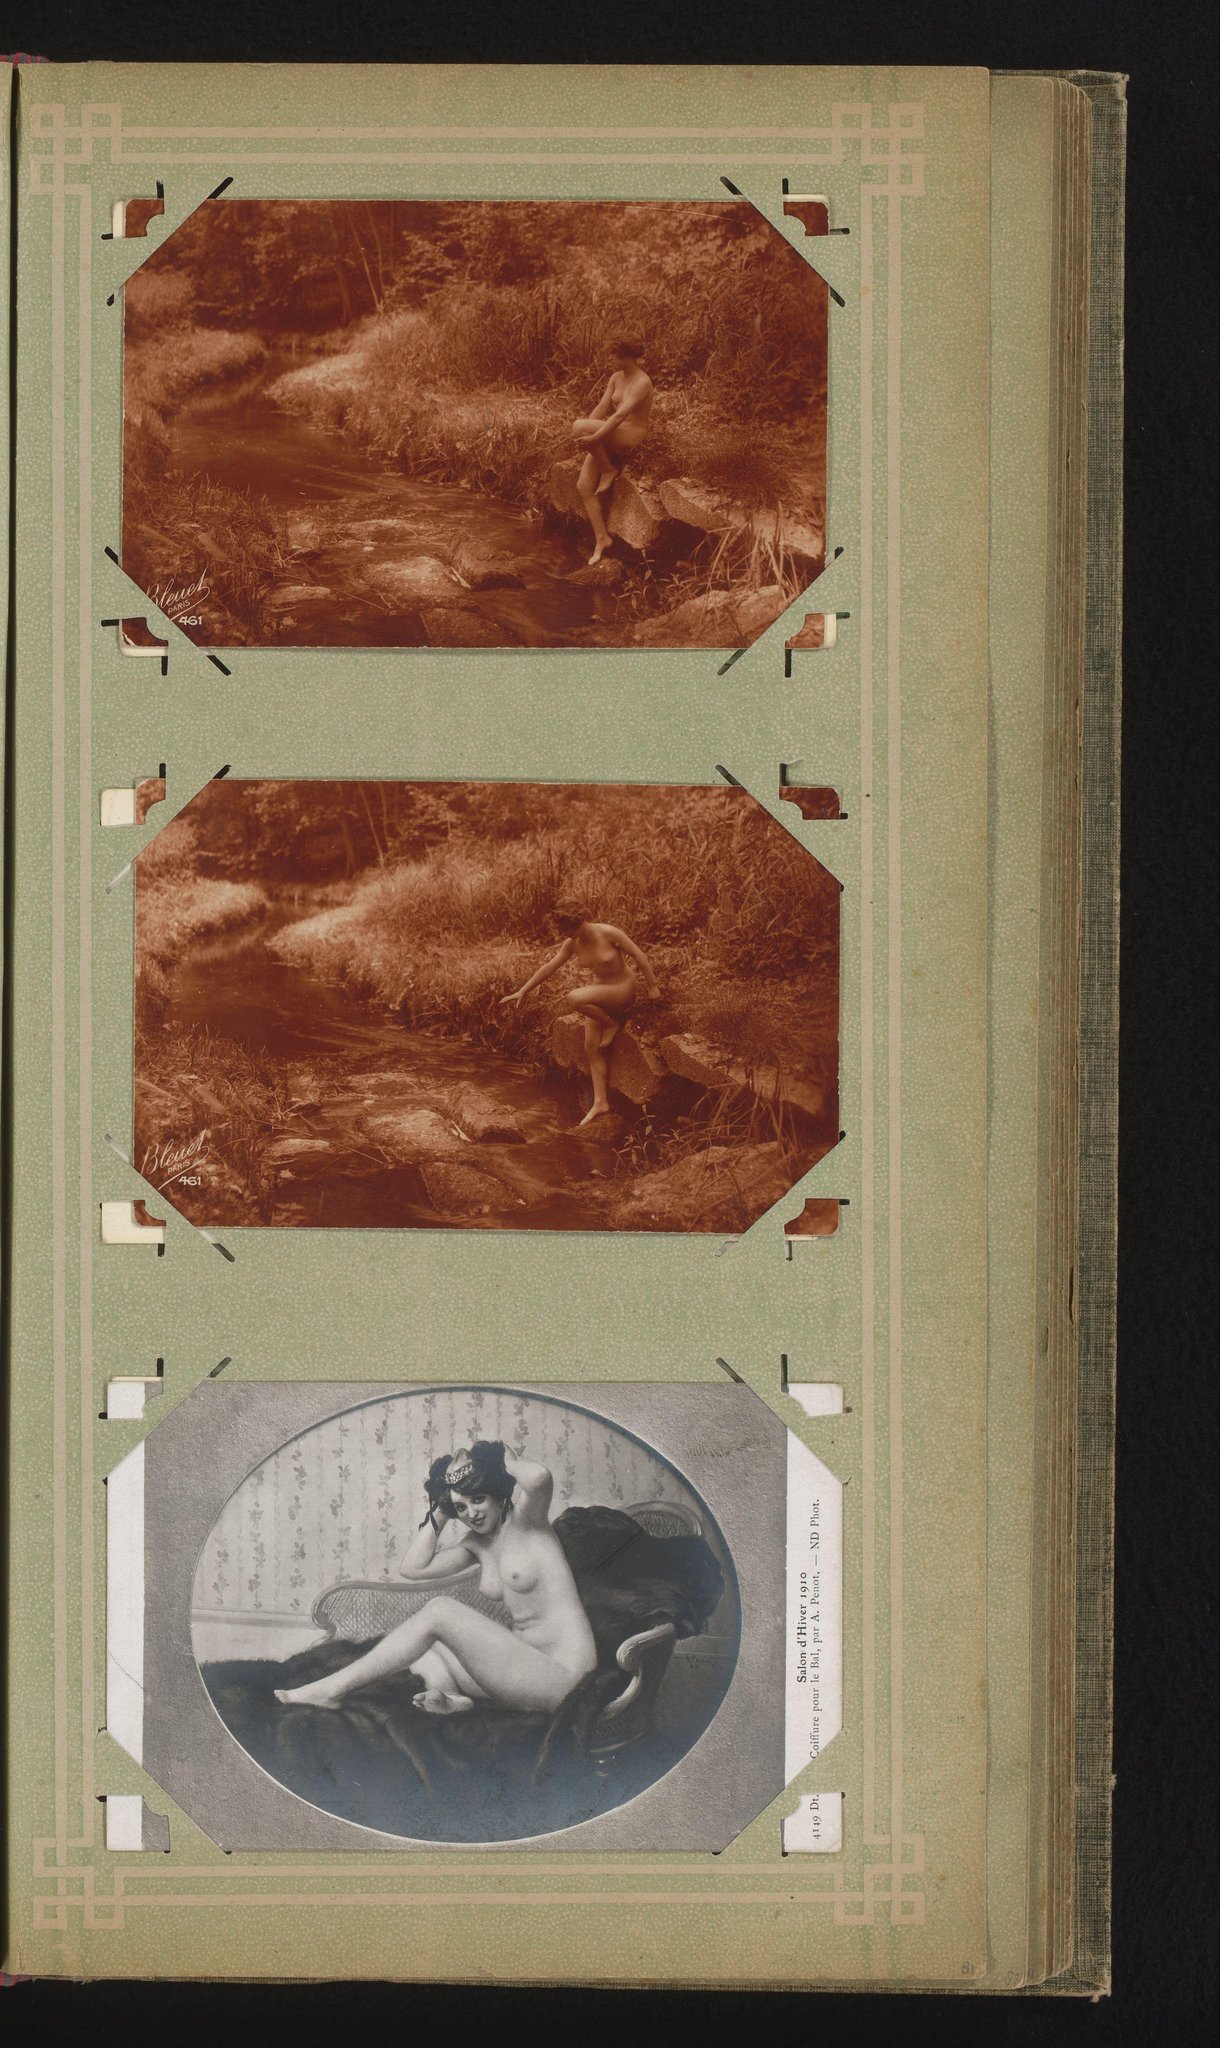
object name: album leaf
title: Drie portretten van naakte vrouwen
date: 1900-1930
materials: cardboard, photographic support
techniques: gelatin silver print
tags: historical persons - bb - woman, woman (showing herself) undressed, quasi-nude, brook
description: Deze foto's maken deel uit van een album.